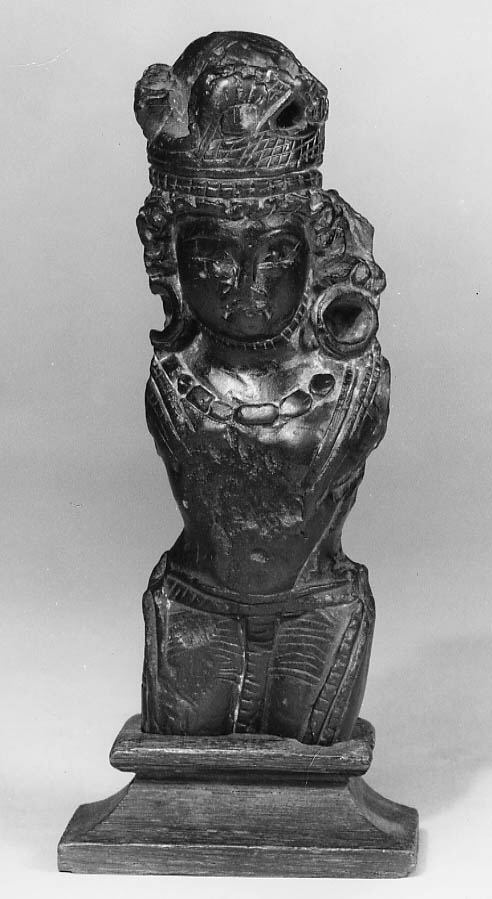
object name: fragment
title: Male Deity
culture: kashmiri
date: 701-800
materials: stone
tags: kashmir,men